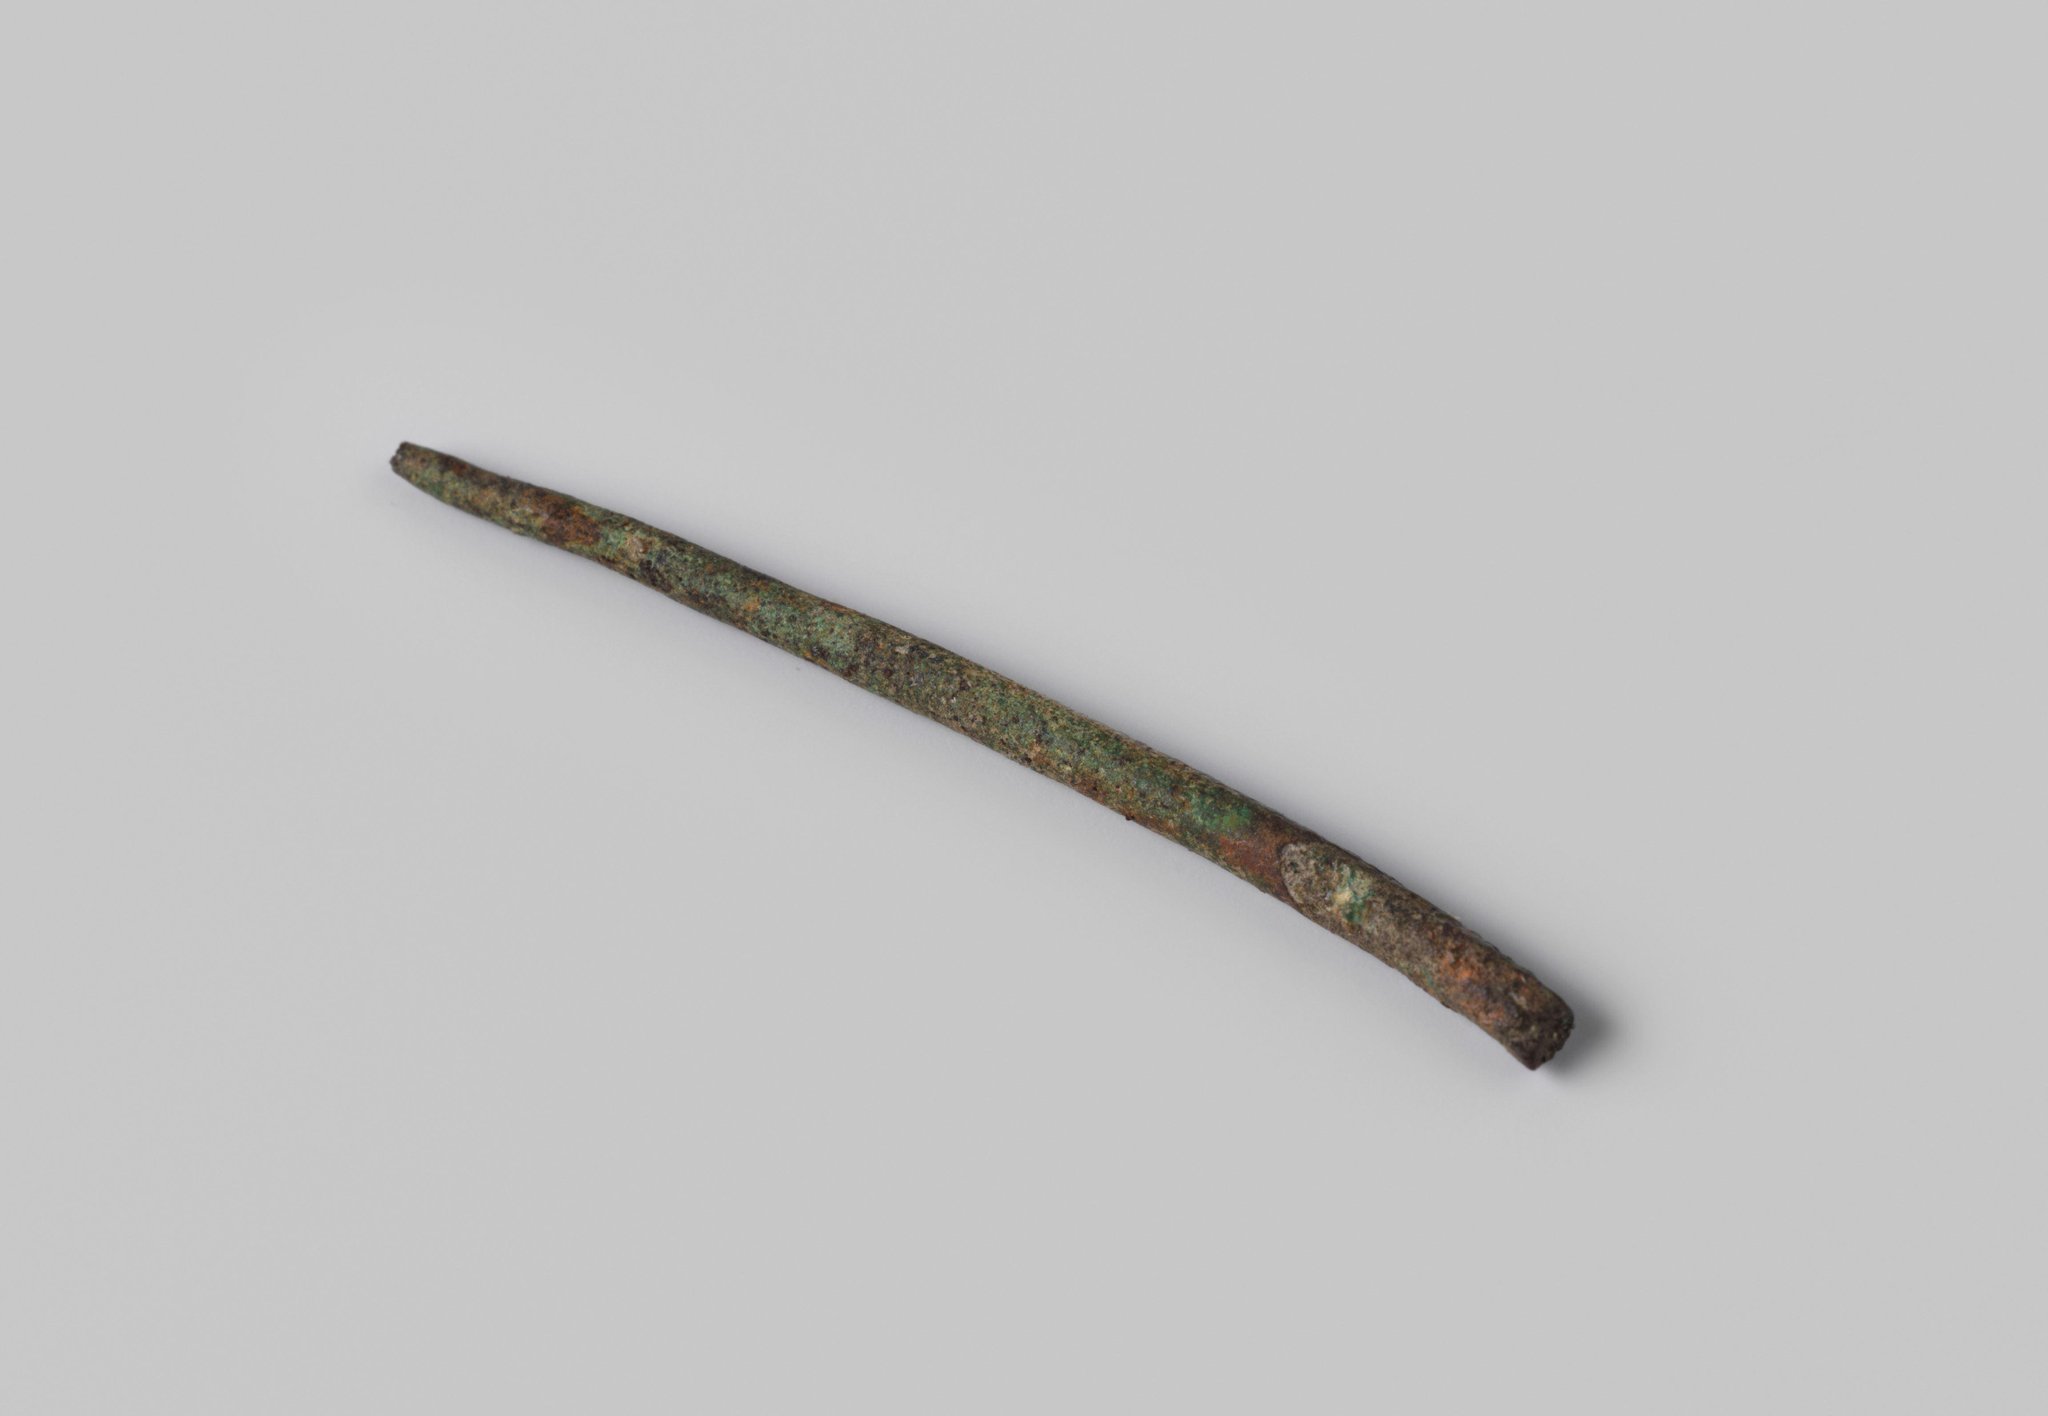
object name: wire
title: Koperdraad uit het wrak van de Oost-Indiëvaarder Hollandia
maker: Anonymous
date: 1700-1743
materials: copper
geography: netherlands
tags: verenigde oostindische compagnie, hollandia (schip), annet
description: Varied parts or fragments, wire; fragm, eroded, circular in section, slightly tapering.